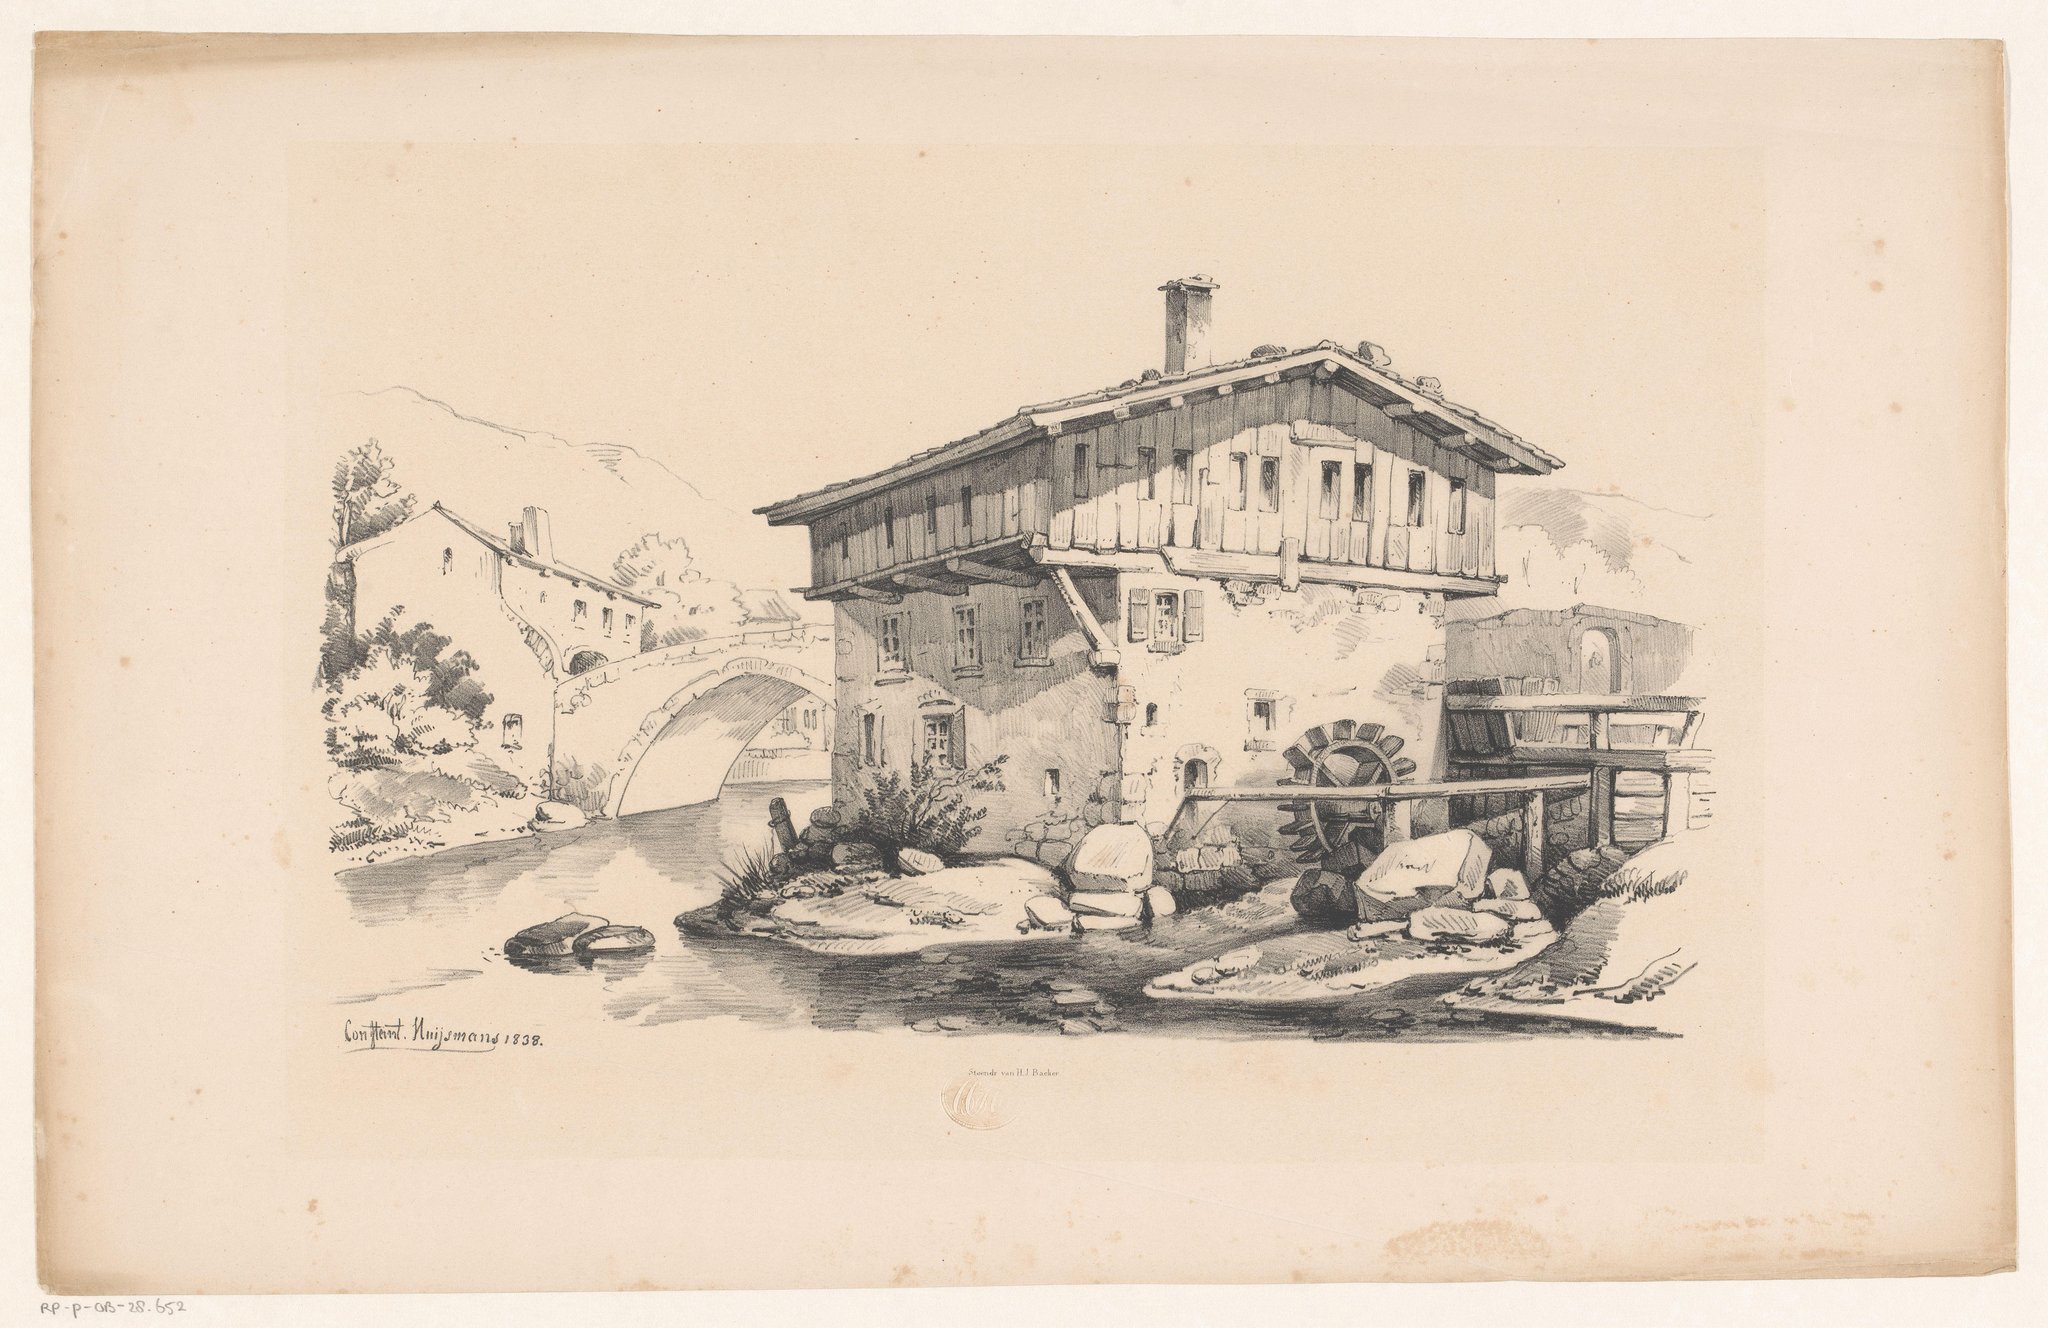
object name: print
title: Het Landschap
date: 1838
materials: paper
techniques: lithograph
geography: dordrecht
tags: watermill in landscape, bridge in village across river, canal, etc.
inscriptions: collector's mark: Lugt 2228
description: Deze prent maakt deel uit van een serie getiteld 'Het Landschap' door Constantinus Cornelis Huysmans. Deze serie werd door hem gebruikt als lesmateriaal op de Koninklijke Militaire Academie te Breda. Hij was docent handtekenen van 1837 tot 1866. Zie: W. van Giersbergen.